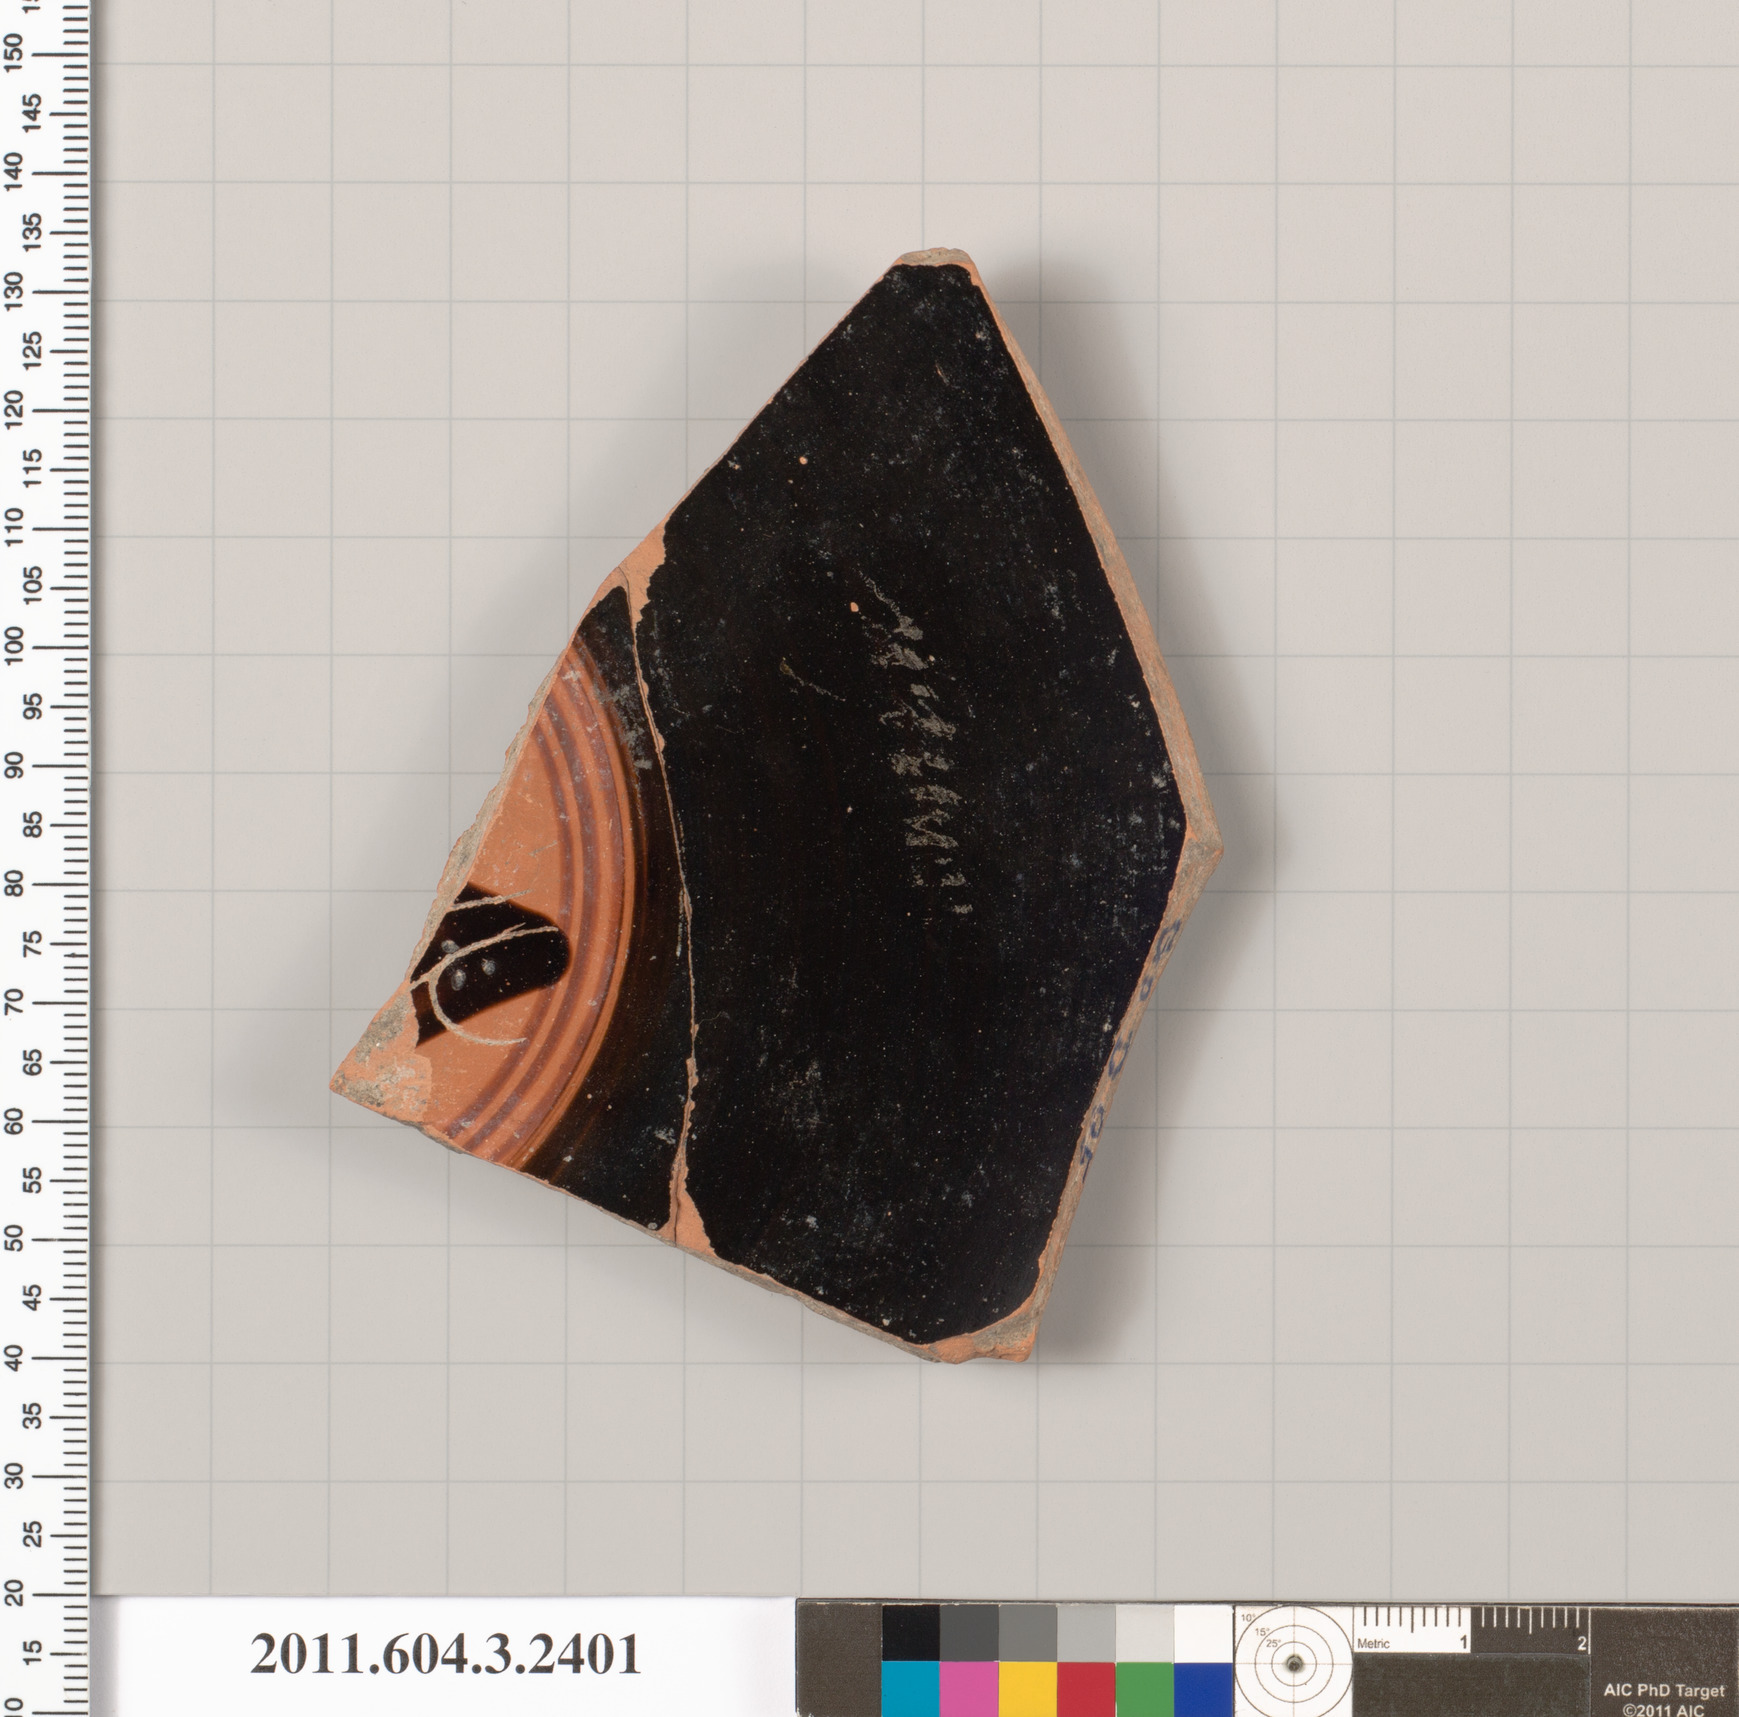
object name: kylix fragment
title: Terracotta fragment of a kylix: eye-cup (drinking cup)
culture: greek, attic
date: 520-500 BCE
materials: terracotta